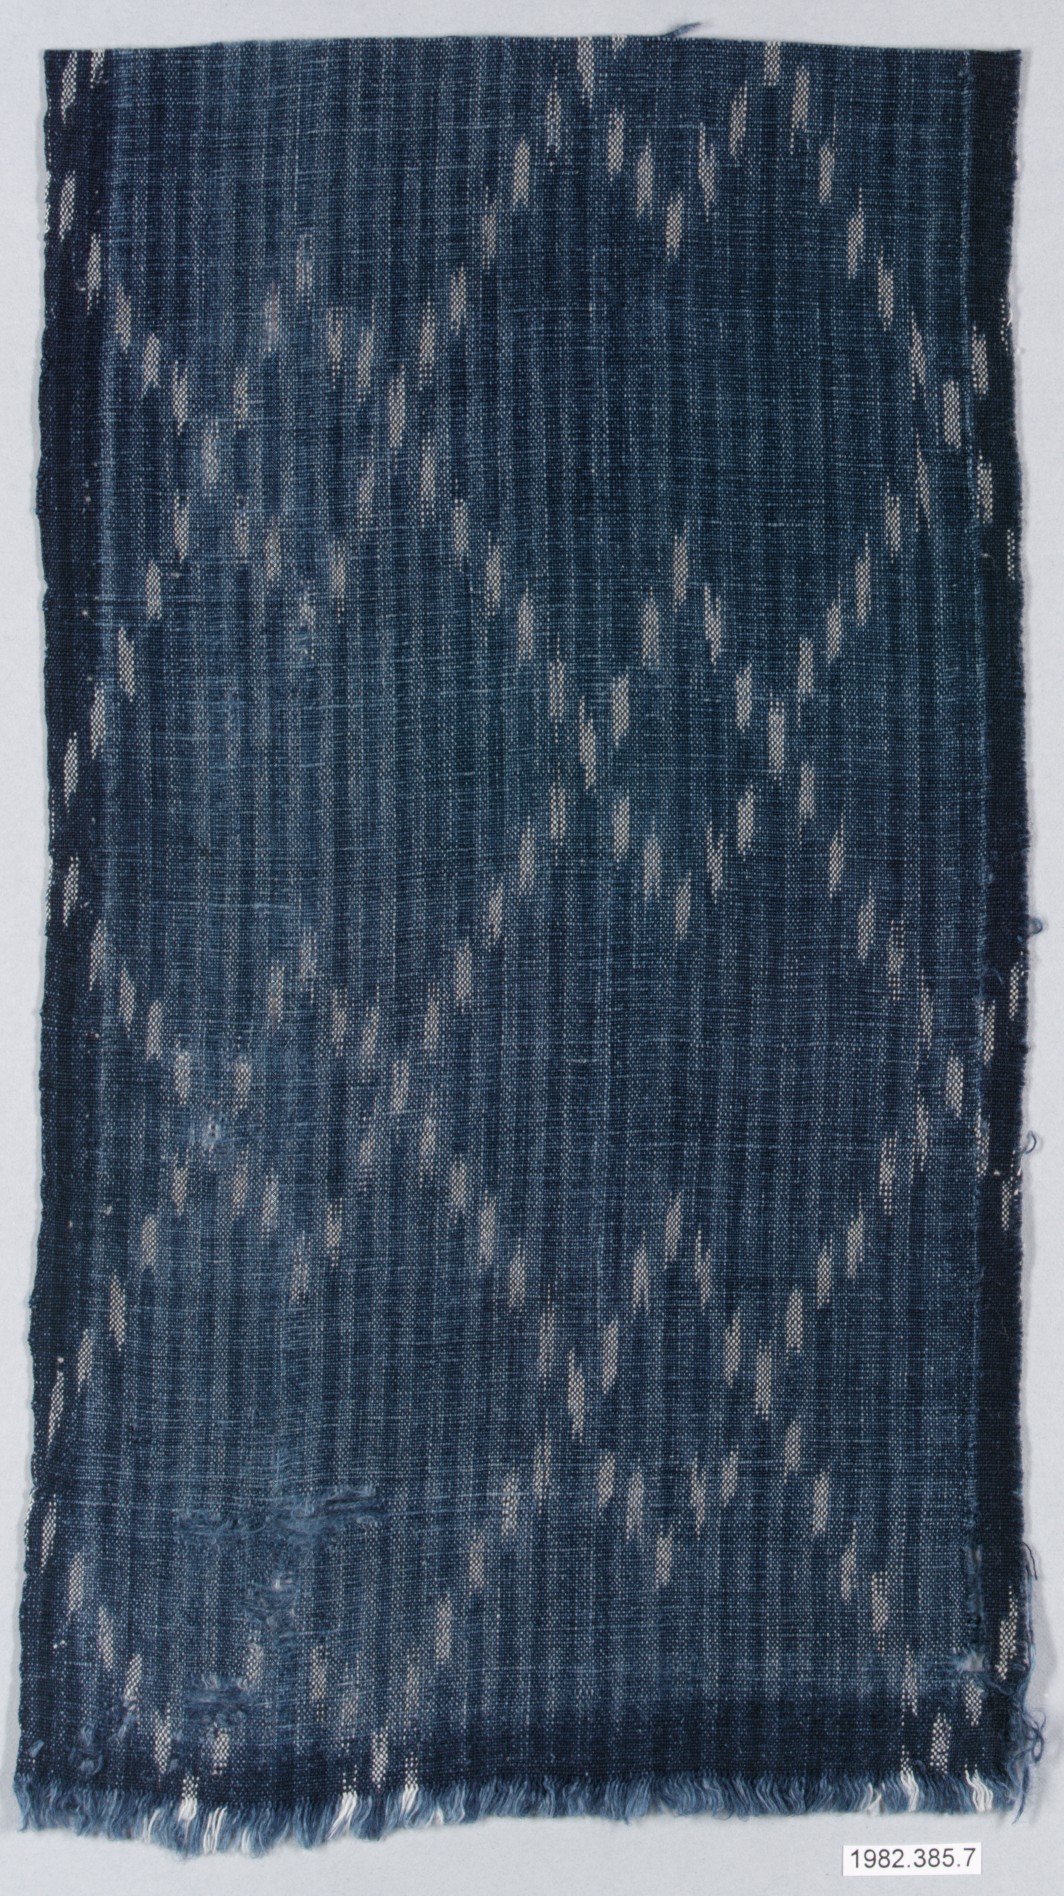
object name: piece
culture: japanese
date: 1868-1926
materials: cotton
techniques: dyeing